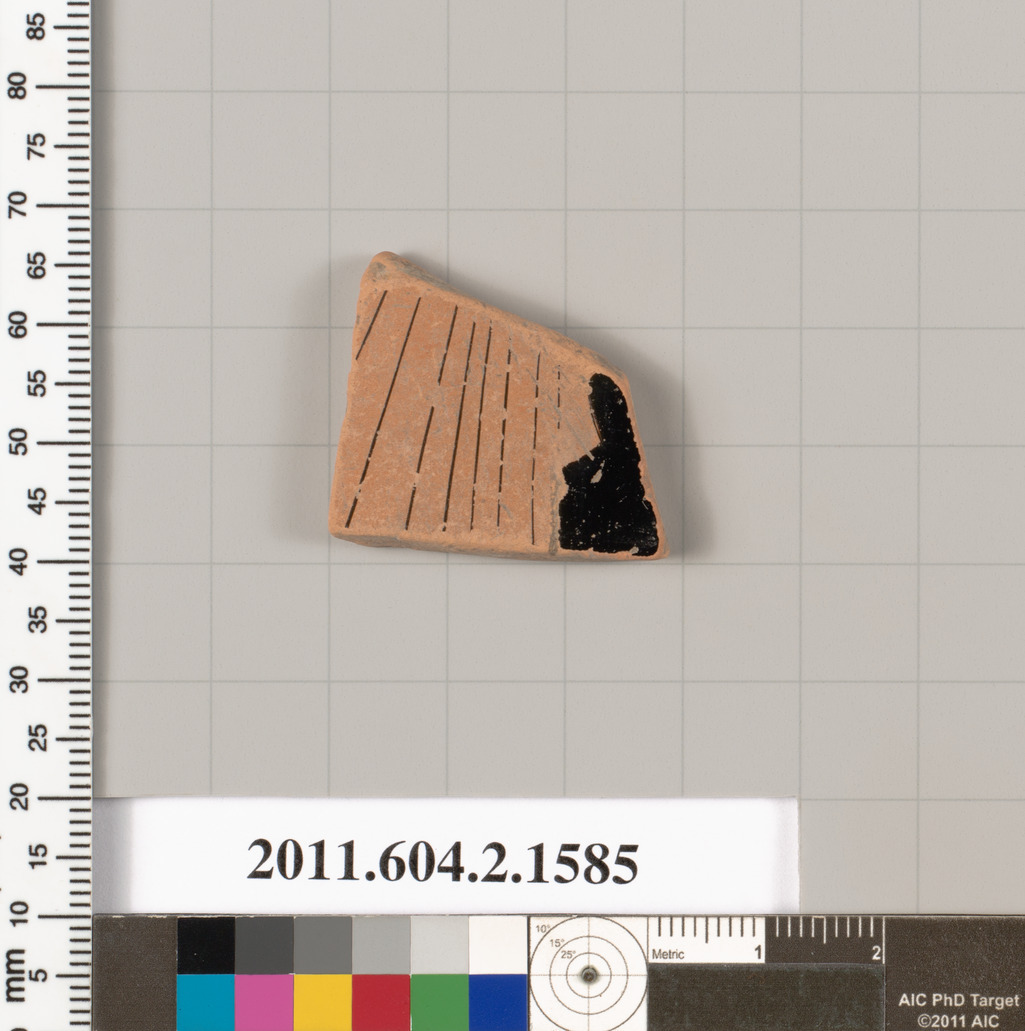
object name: skyphos fragment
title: Terracotta fragment of a skyphos (deep drinking cup)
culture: greek, attic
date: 460-440 BCE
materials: terracotta